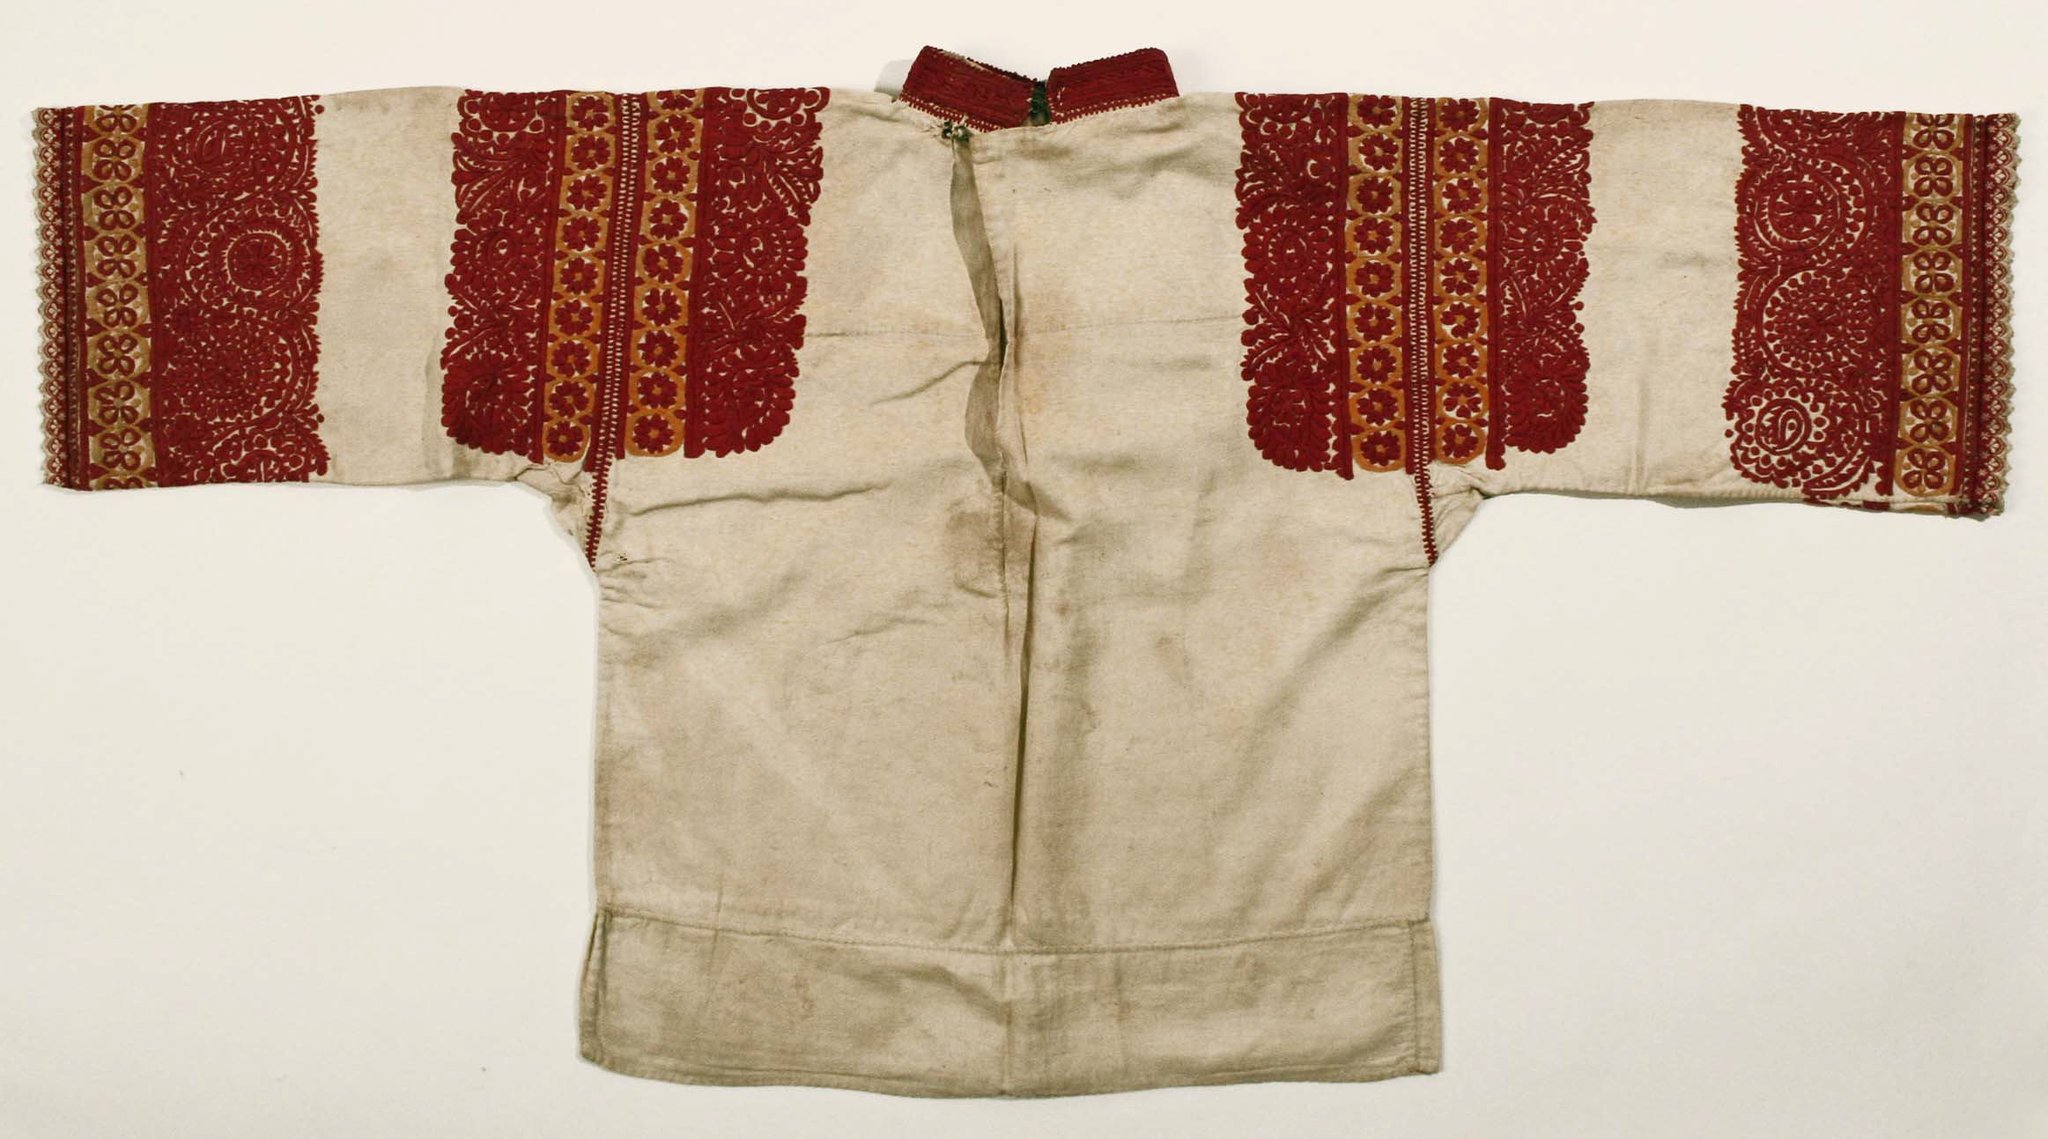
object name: shirt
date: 1801-1900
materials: linen